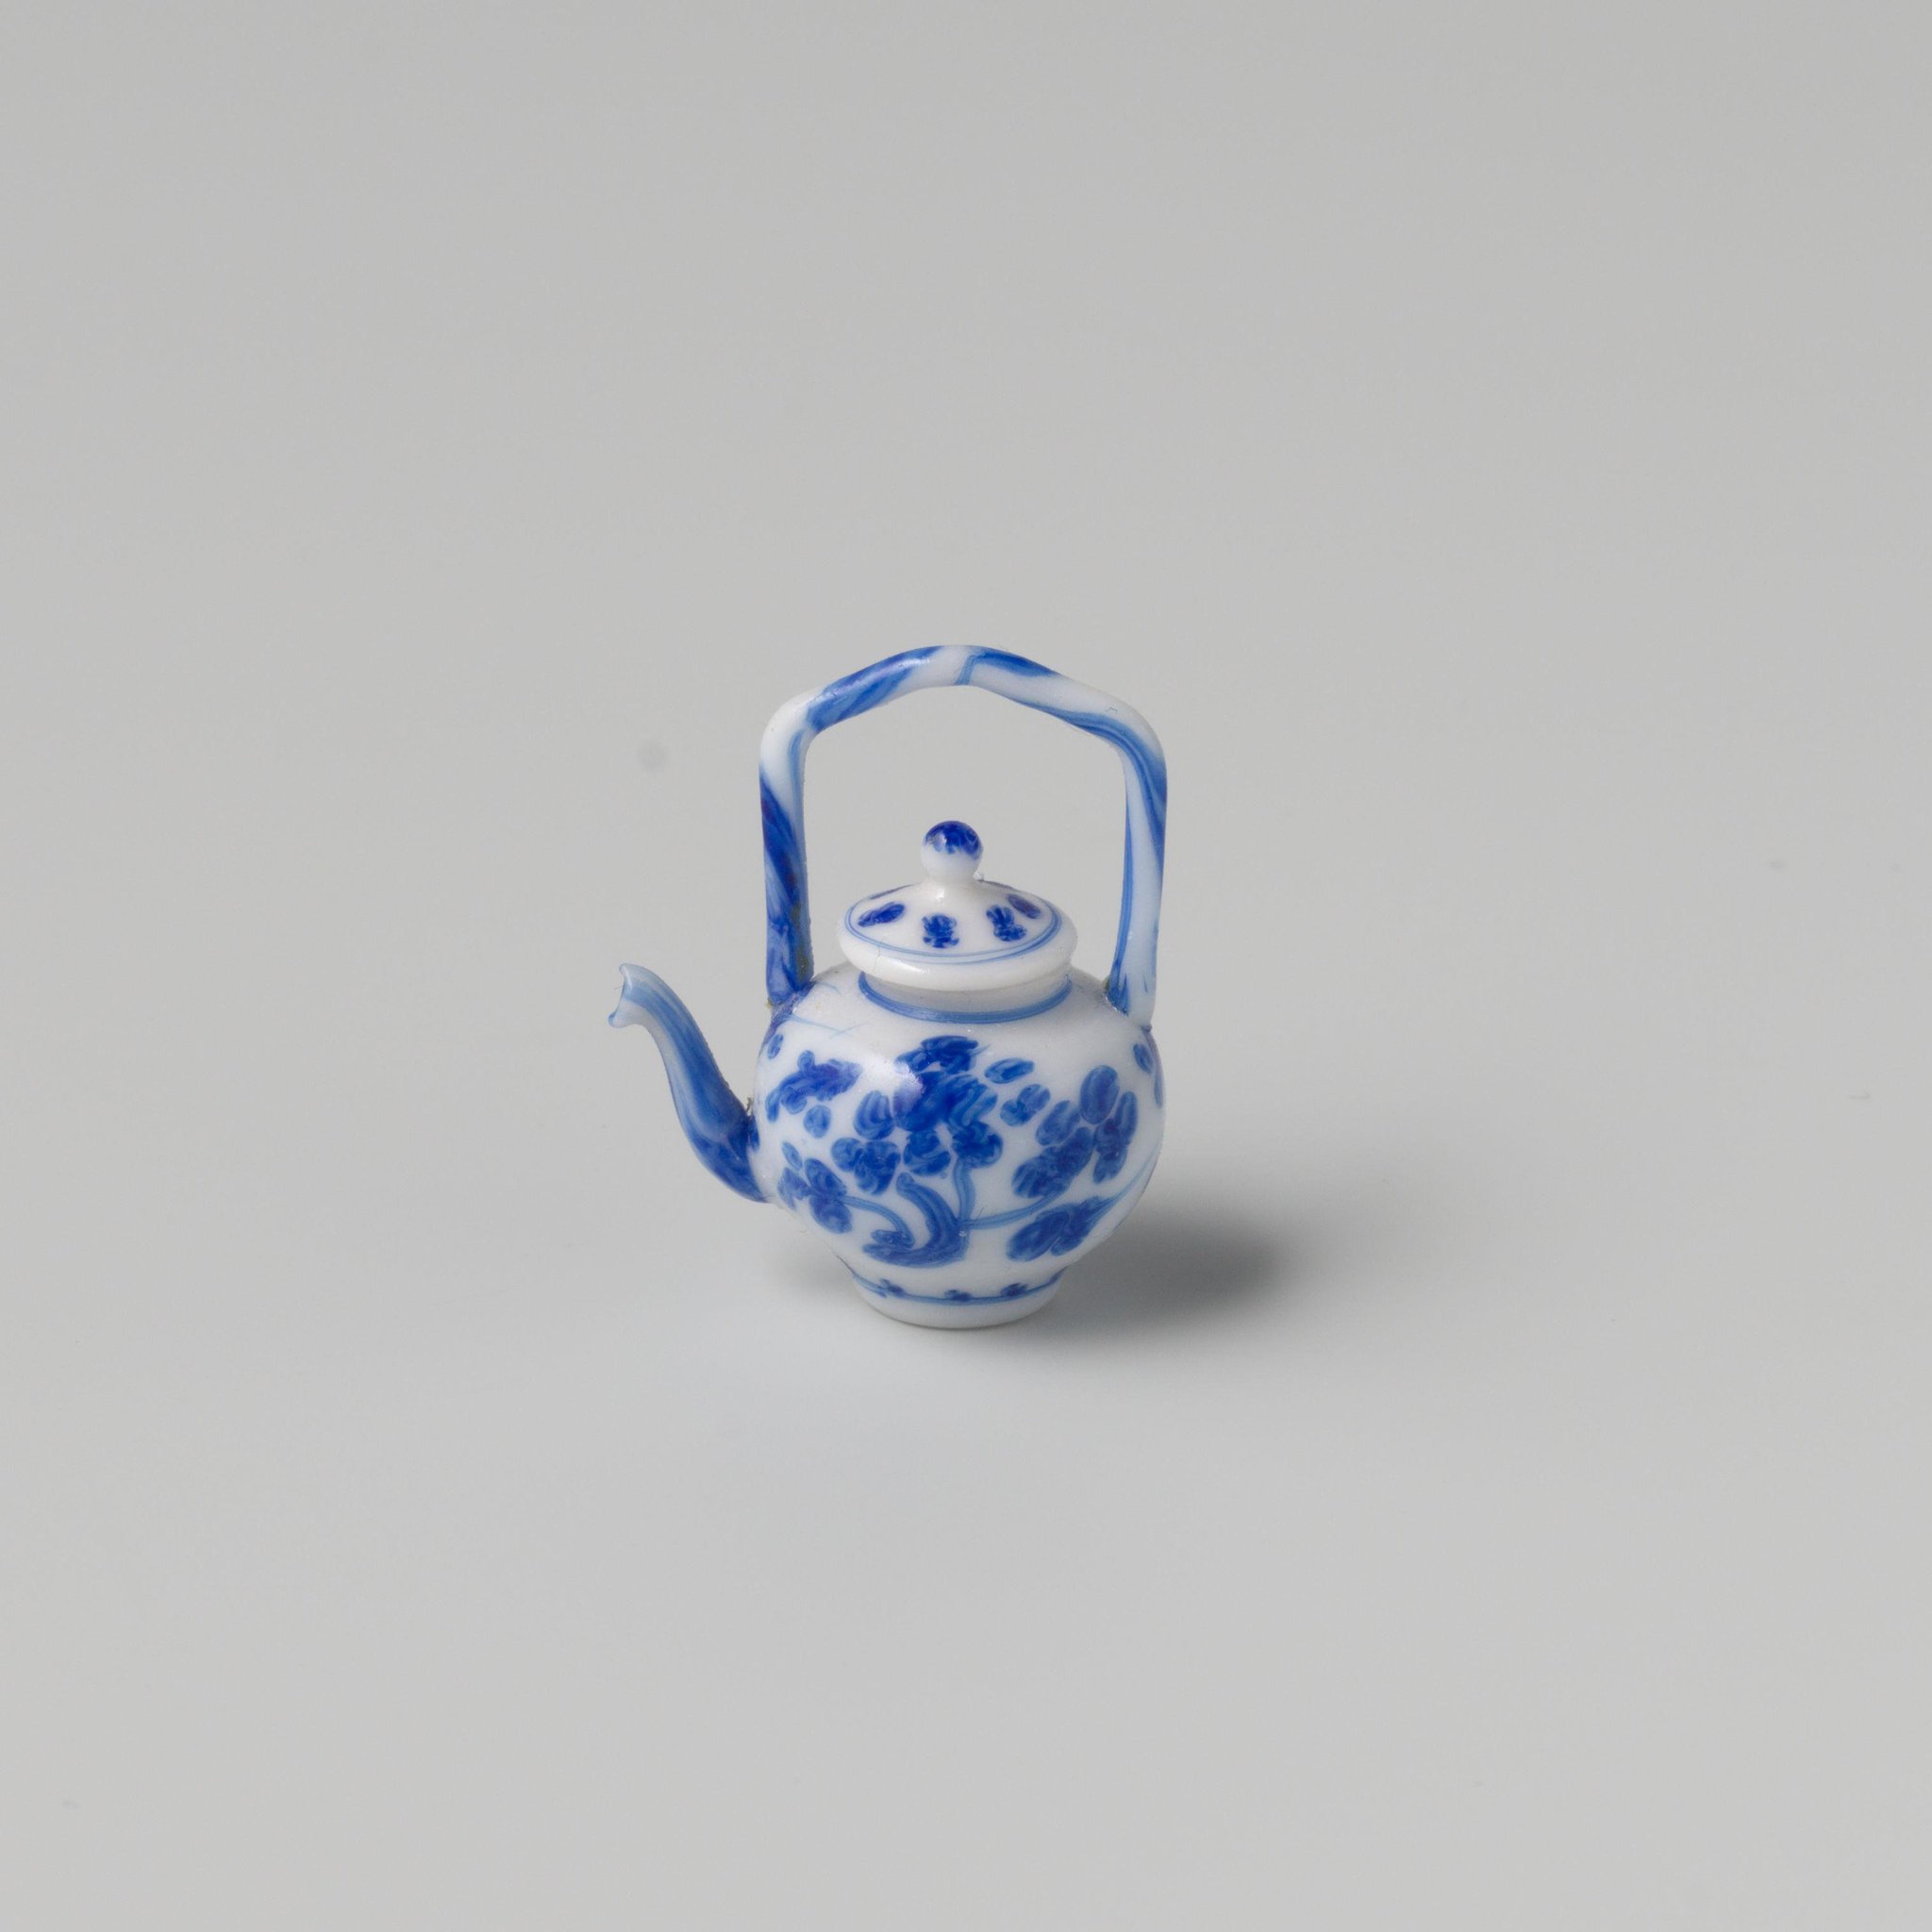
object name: teapot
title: Theepot of wijnketel van melkglas met blauwe emailverf beschildering, imitatie Chinees porselein; bolvormig met tuit en hoog vast hengsel en losse deksel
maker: Anonymous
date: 1675-1710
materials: glass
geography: amsterdam